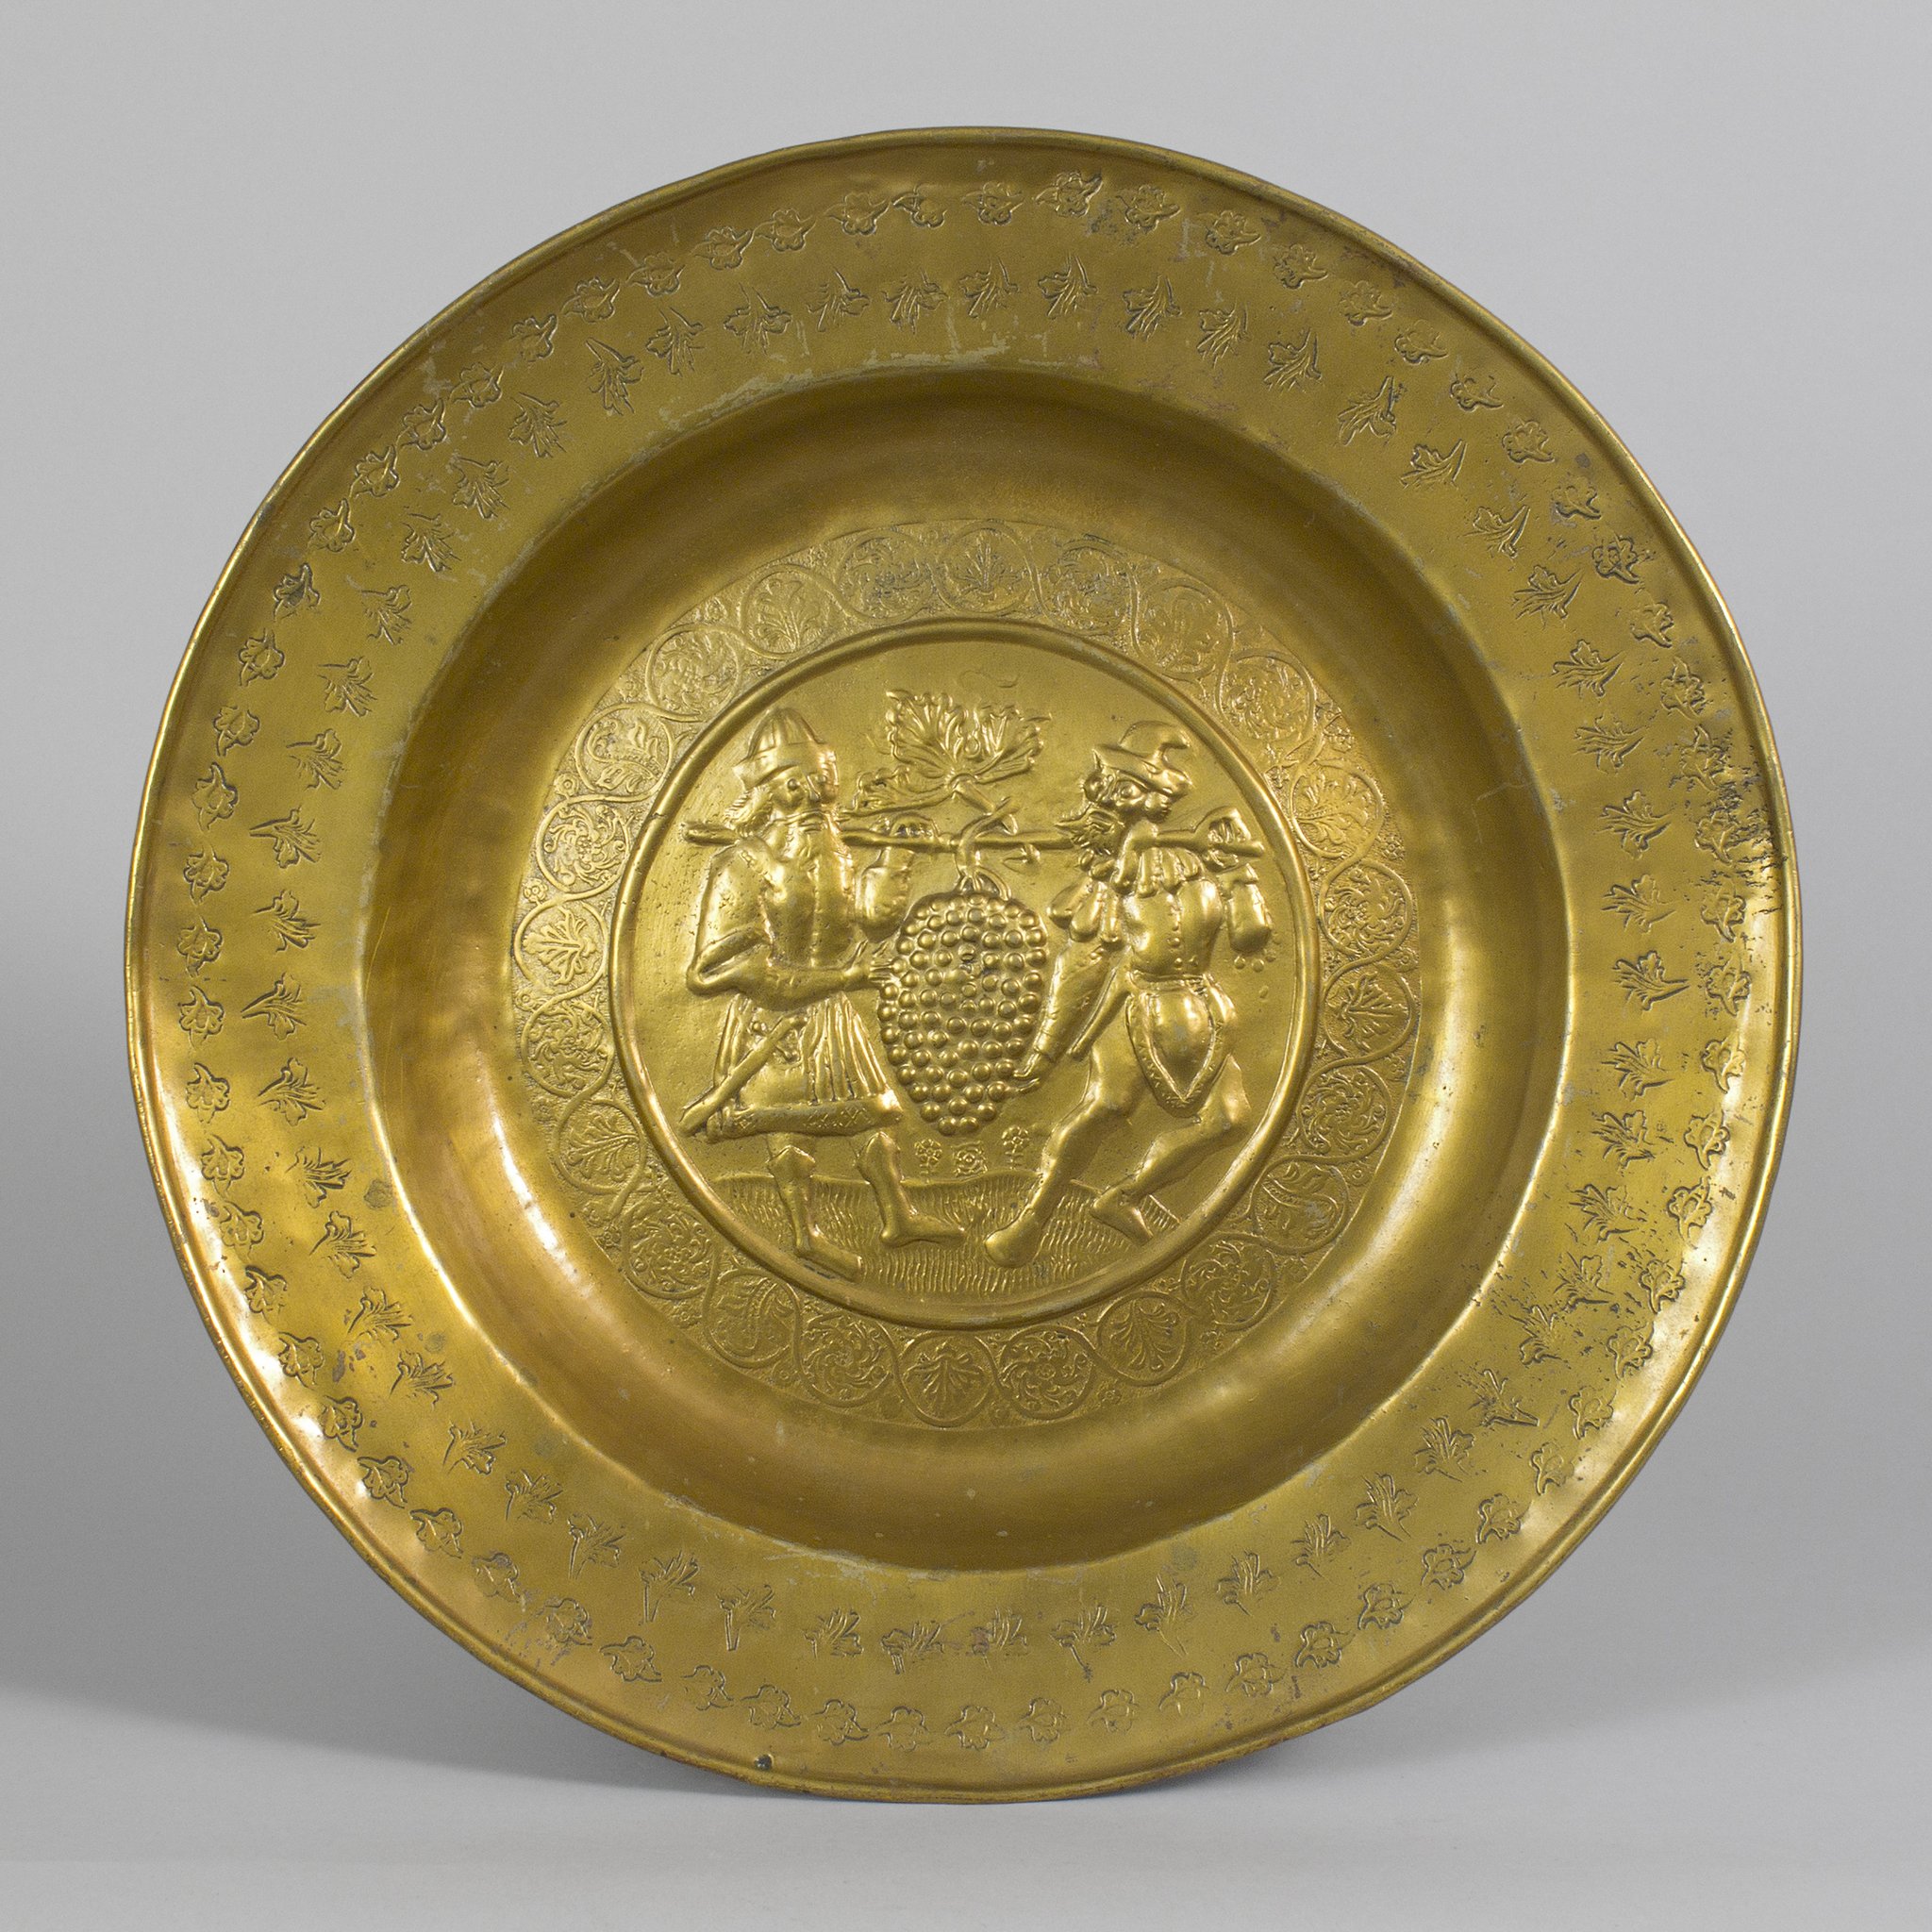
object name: dish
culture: german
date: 1501-1533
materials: brass